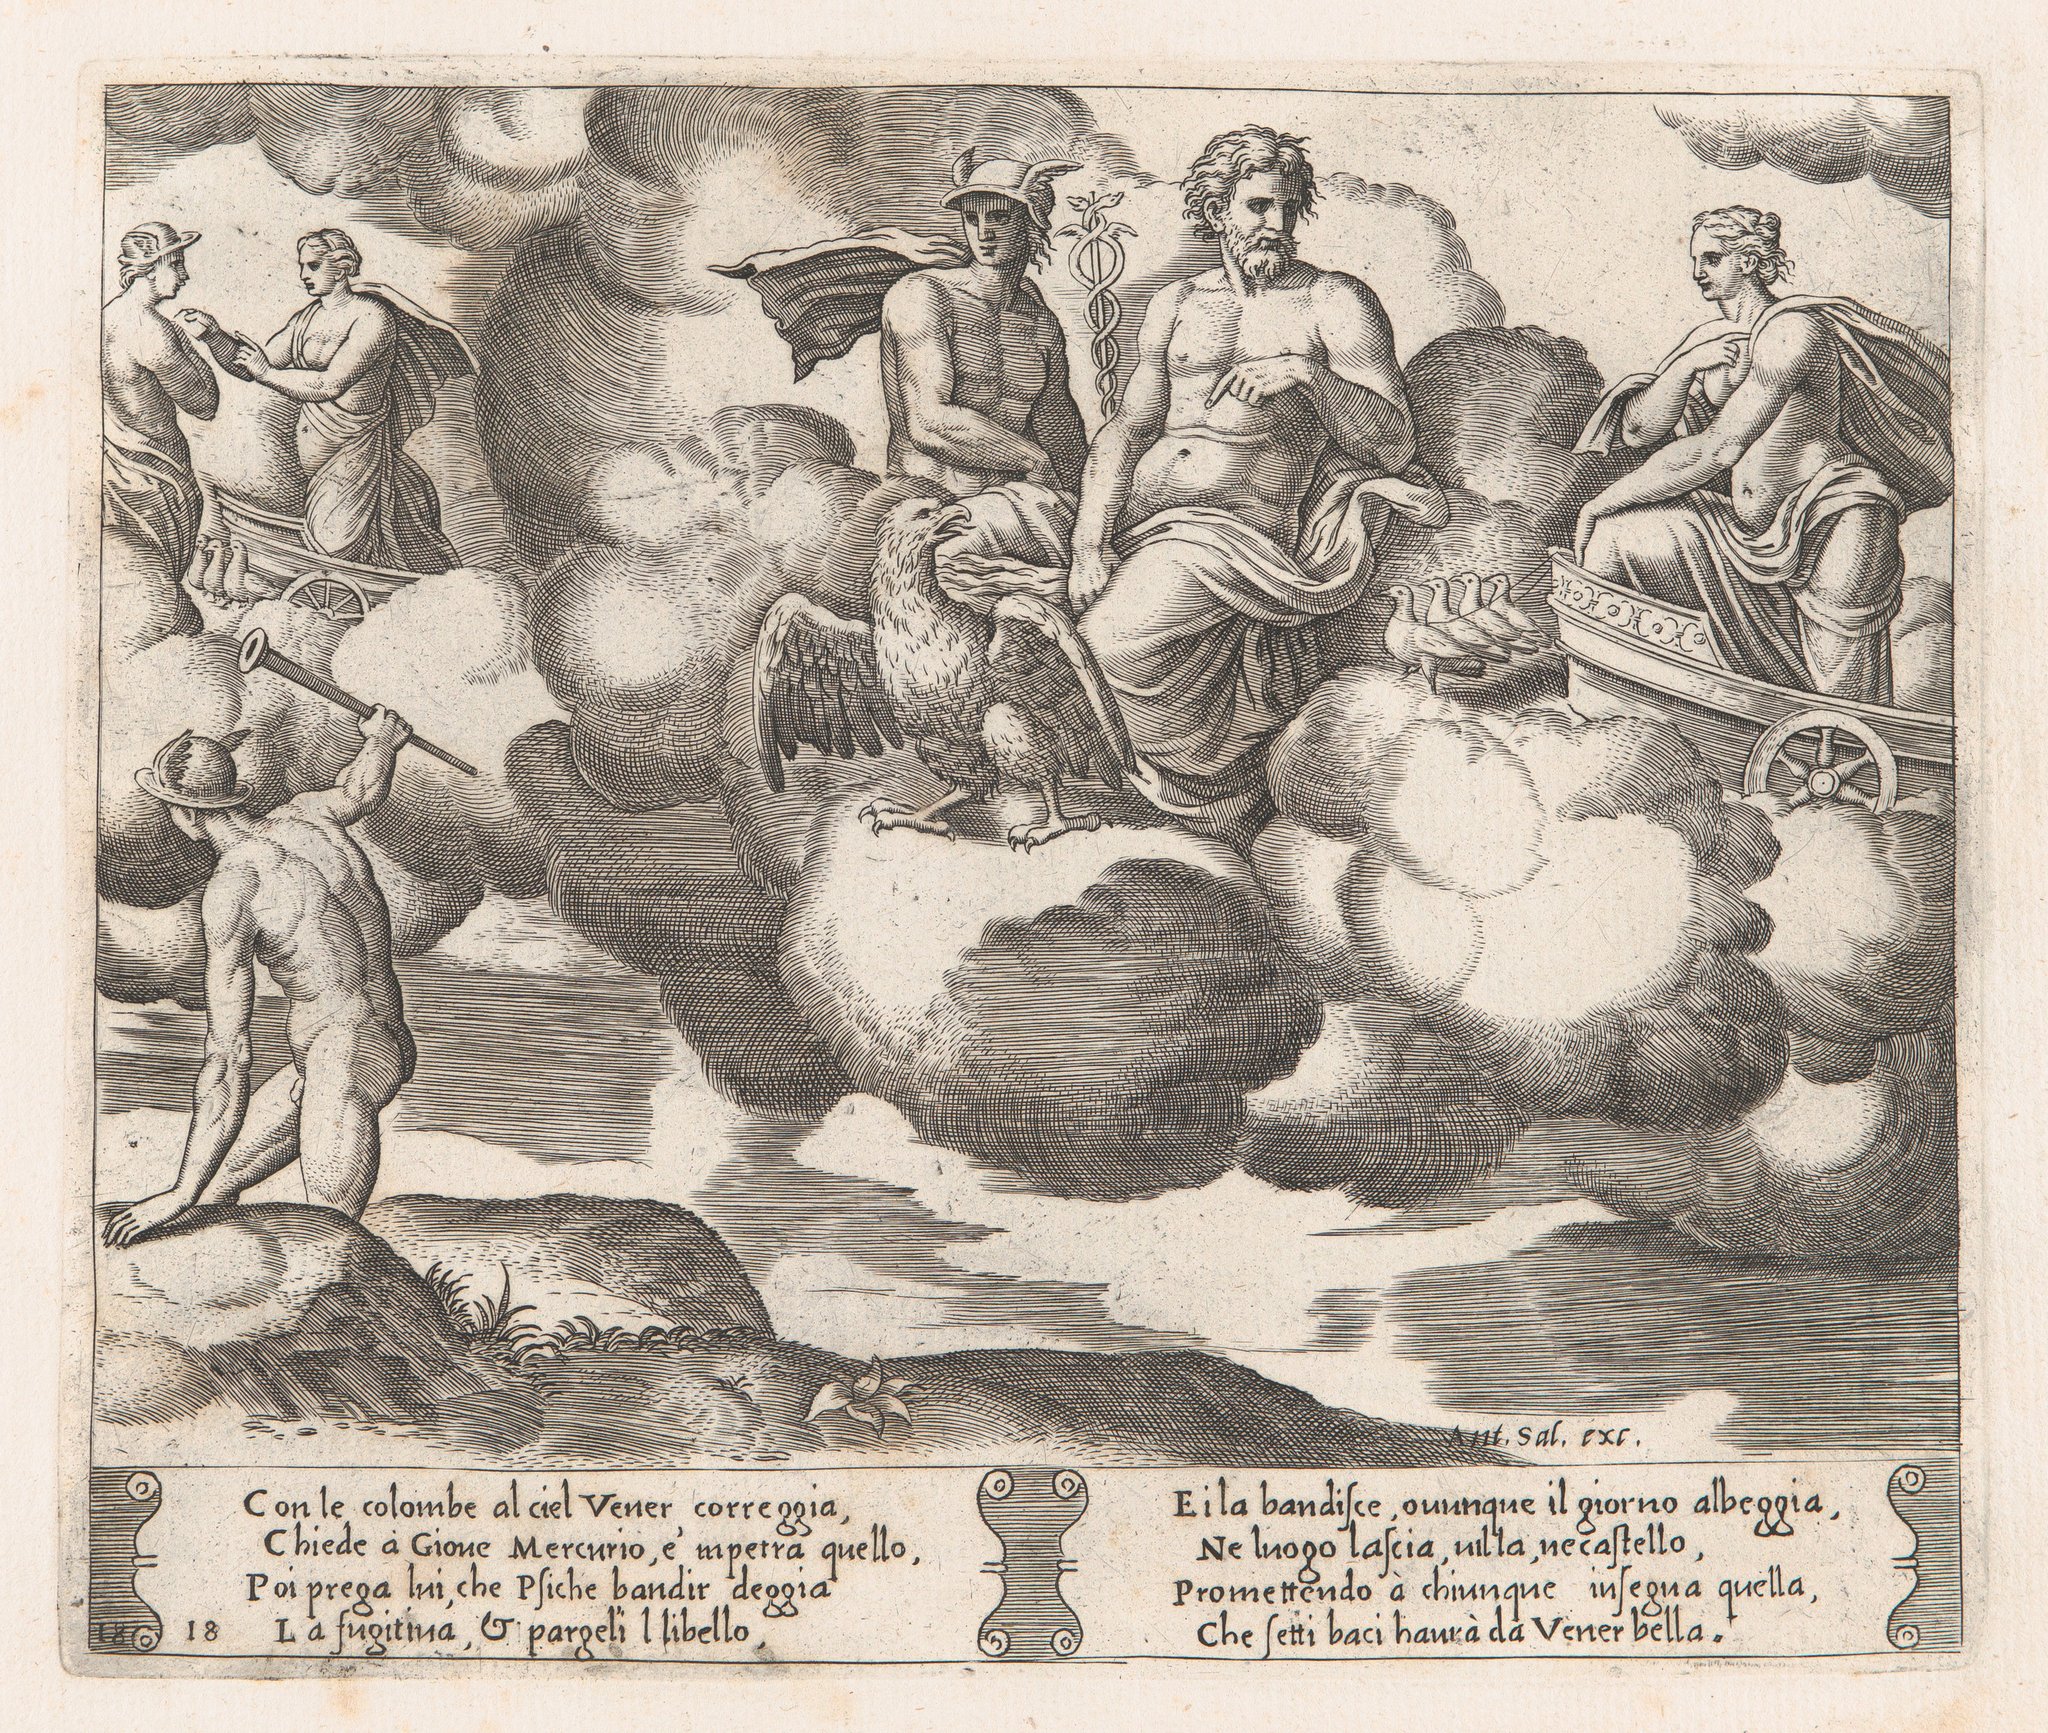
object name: print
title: Plate 18: Venus in her dove-drawn chariot complaining to Jupiter, who is accompanied by Mercury and an eagle, at left Mercury has descended to earth, from "The Story of Cupid and Psyche as told by Apuleius"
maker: master of the die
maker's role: artist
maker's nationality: italian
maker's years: 1525-1560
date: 1530-1560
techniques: engraving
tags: eagles,jupiter,mercury,venus